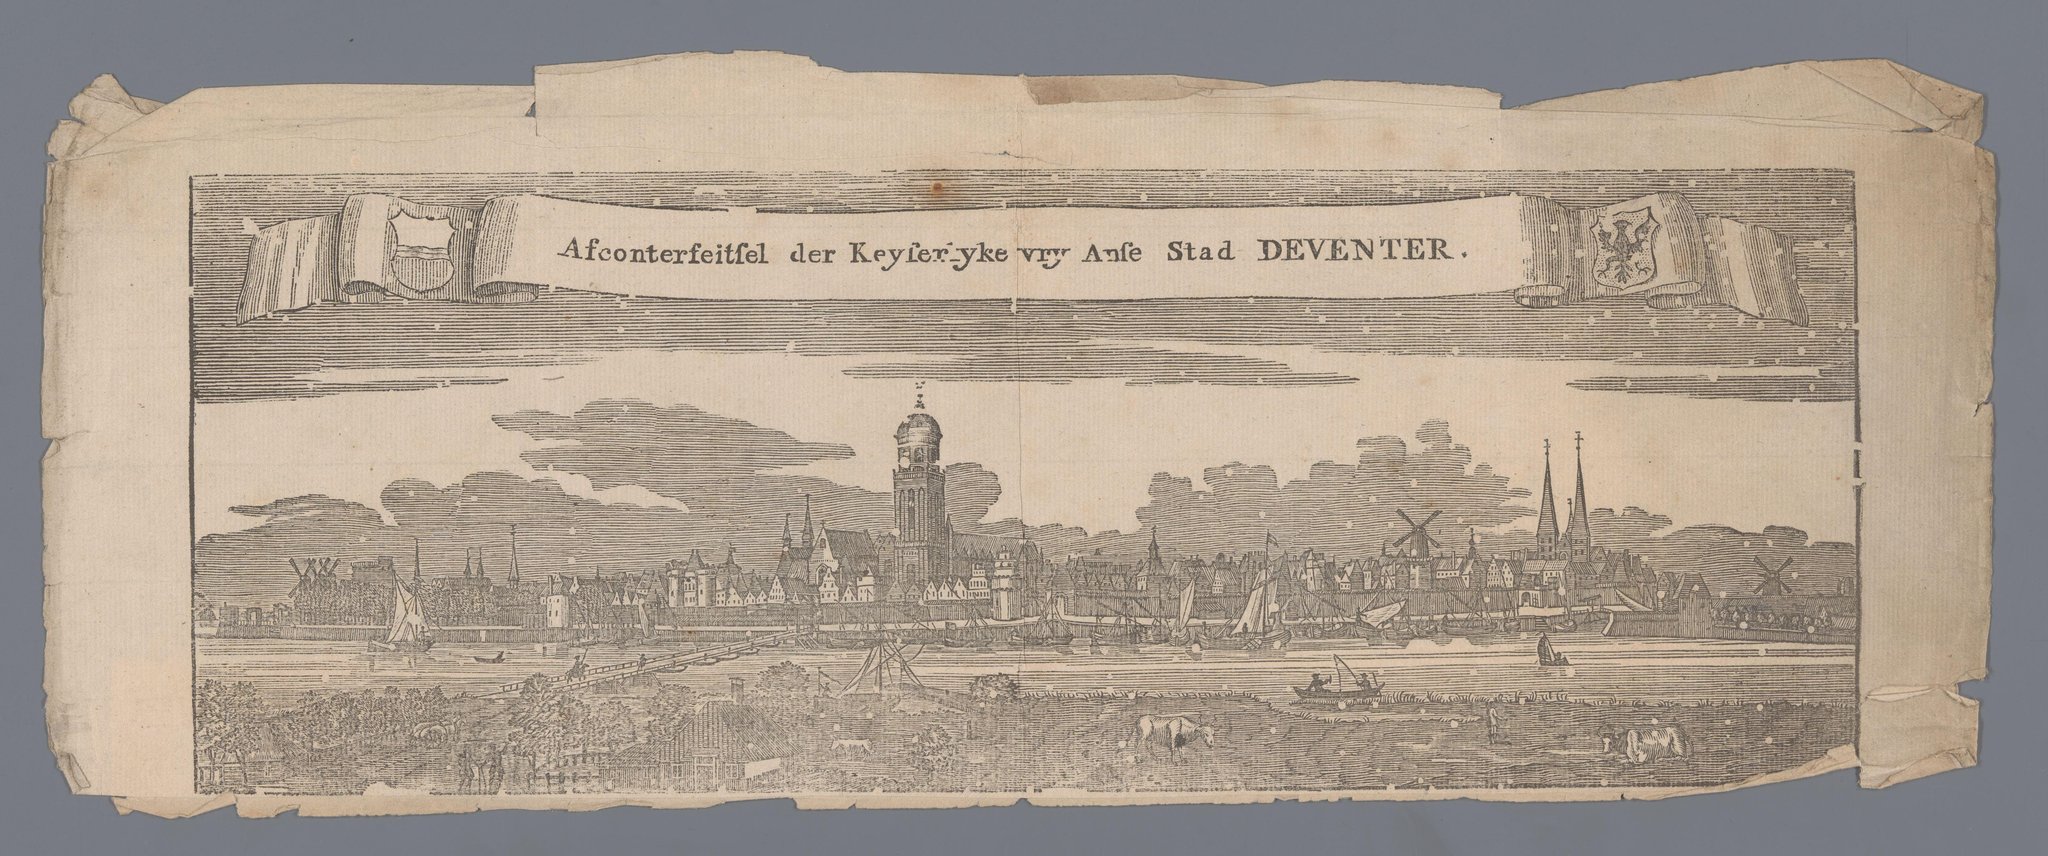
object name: print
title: Gezicht op Deventer vanaf de overkant van de IJssel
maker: Anonymous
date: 1770-1800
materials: paper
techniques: woodcut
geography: netherlands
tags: city-view, and landscape with man-made constructions, river, deventer